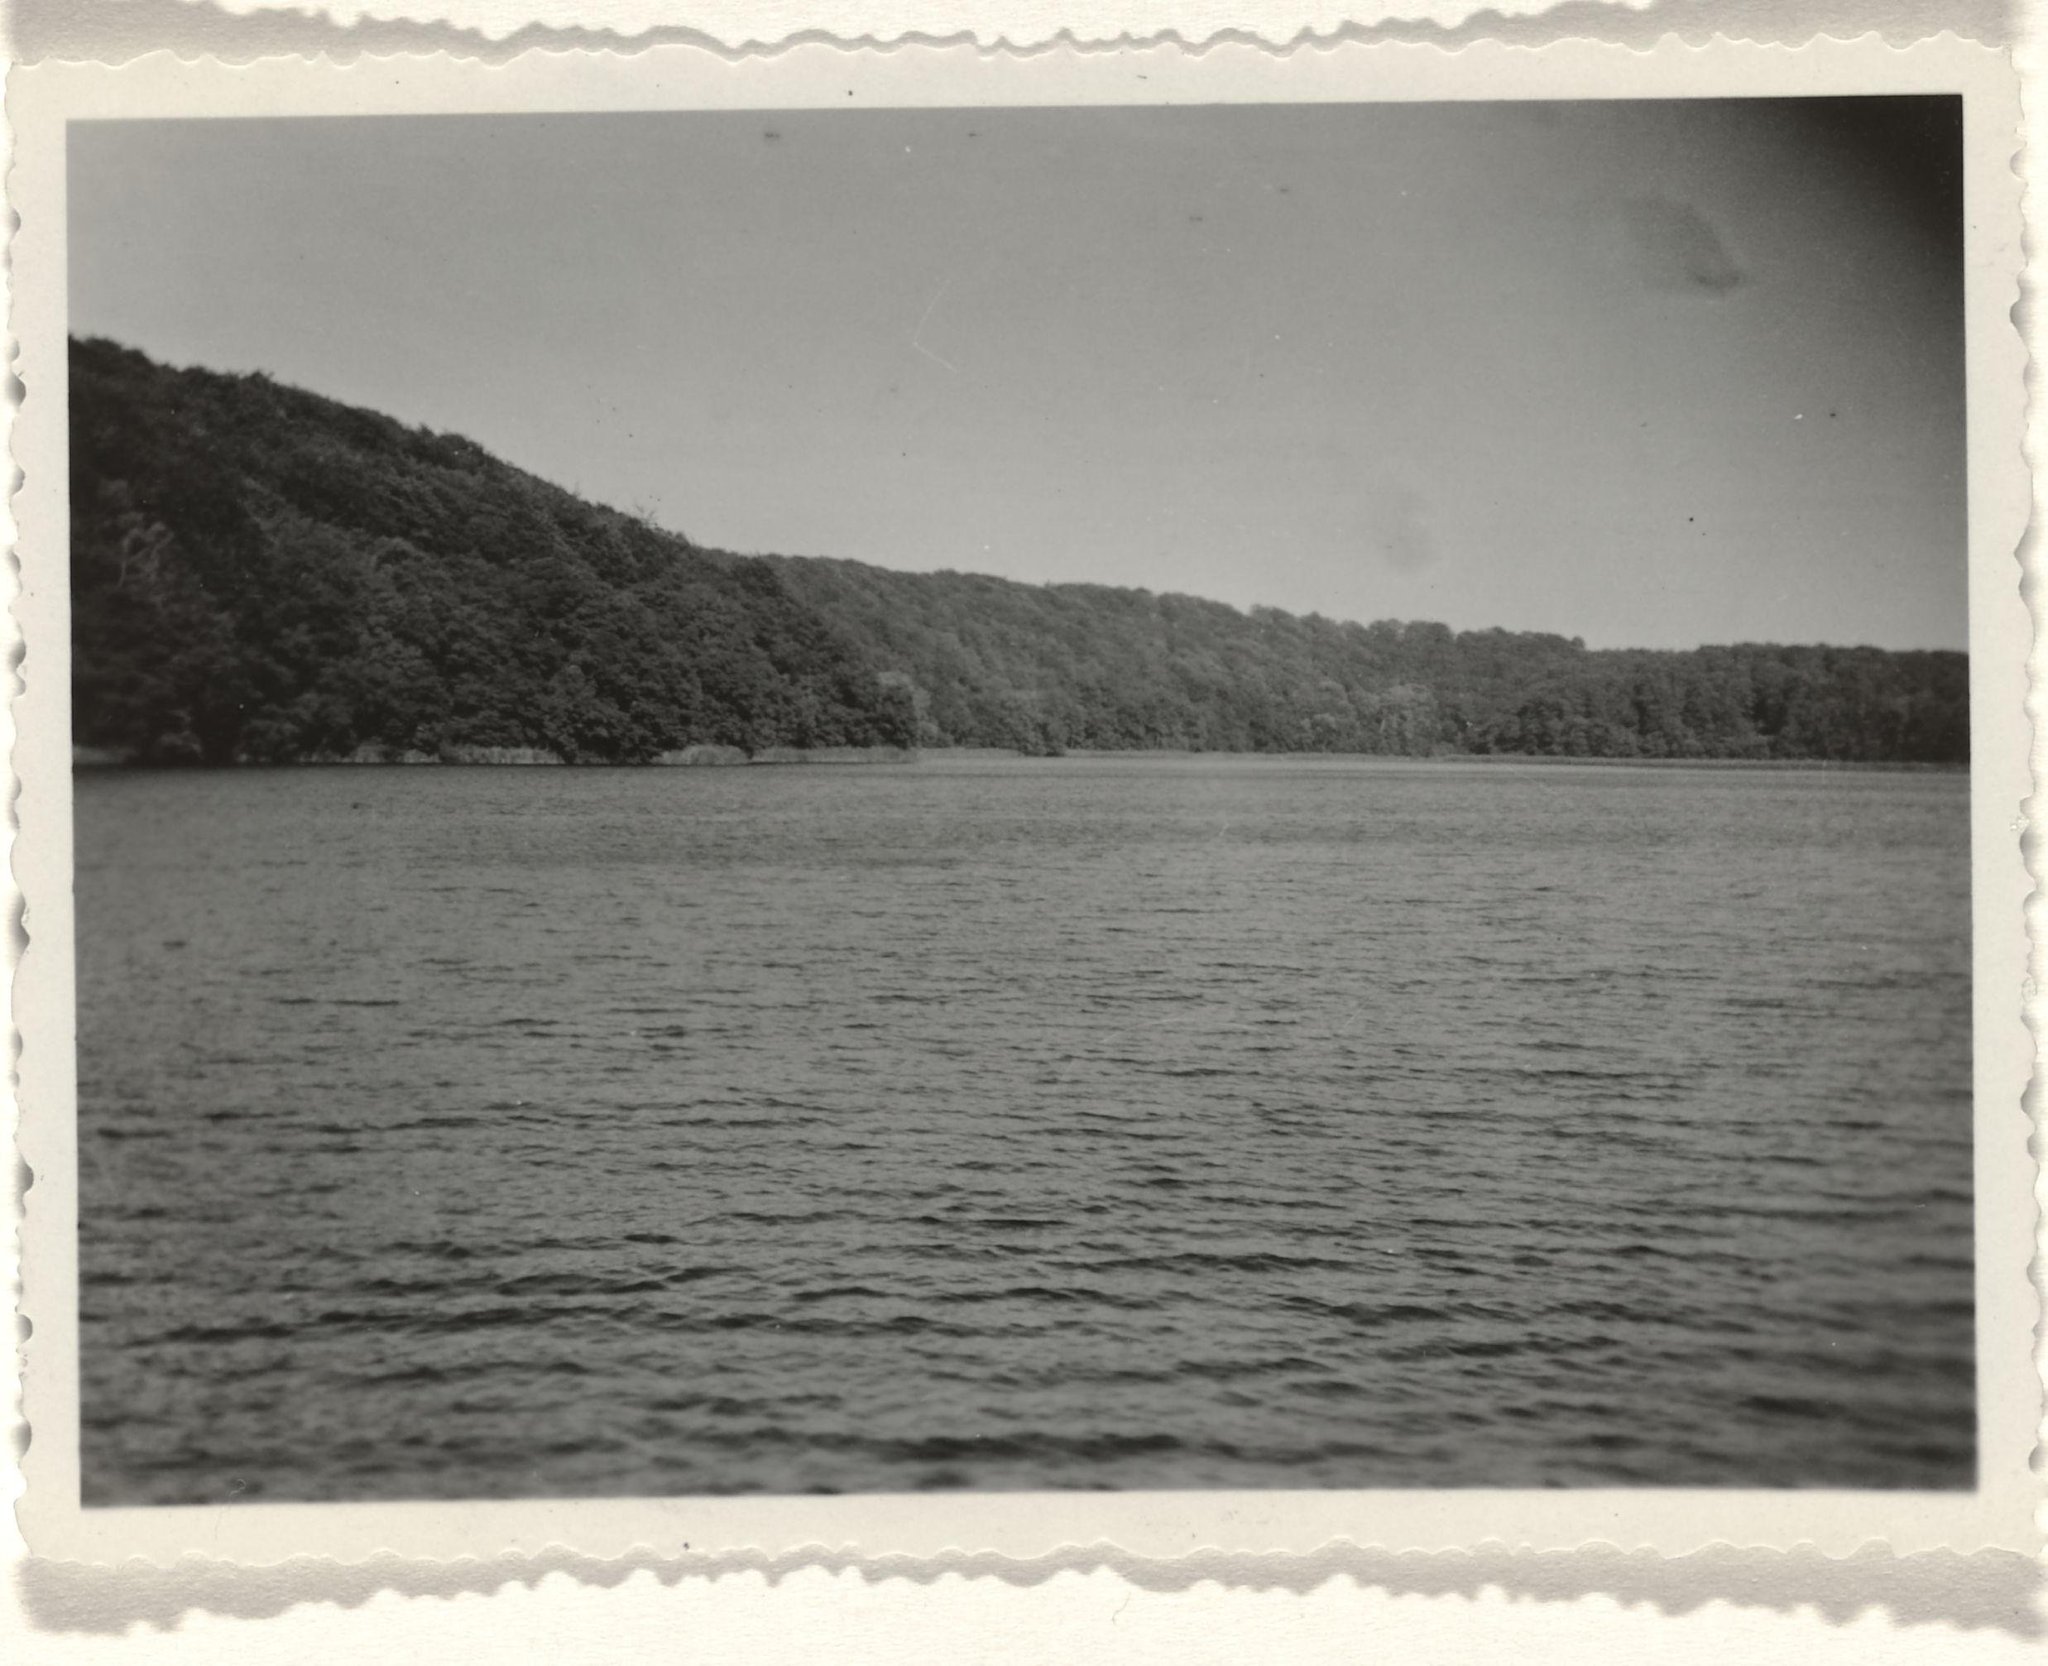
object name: photograph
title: Met bergen omringd meer bij de Zwitserse plaats Holstein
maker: Anonymous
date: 1909-1934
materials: photographic support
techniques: gelatin silver print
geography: switzerland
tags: trübsee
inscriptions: date: ‘Sept. 34. 12’